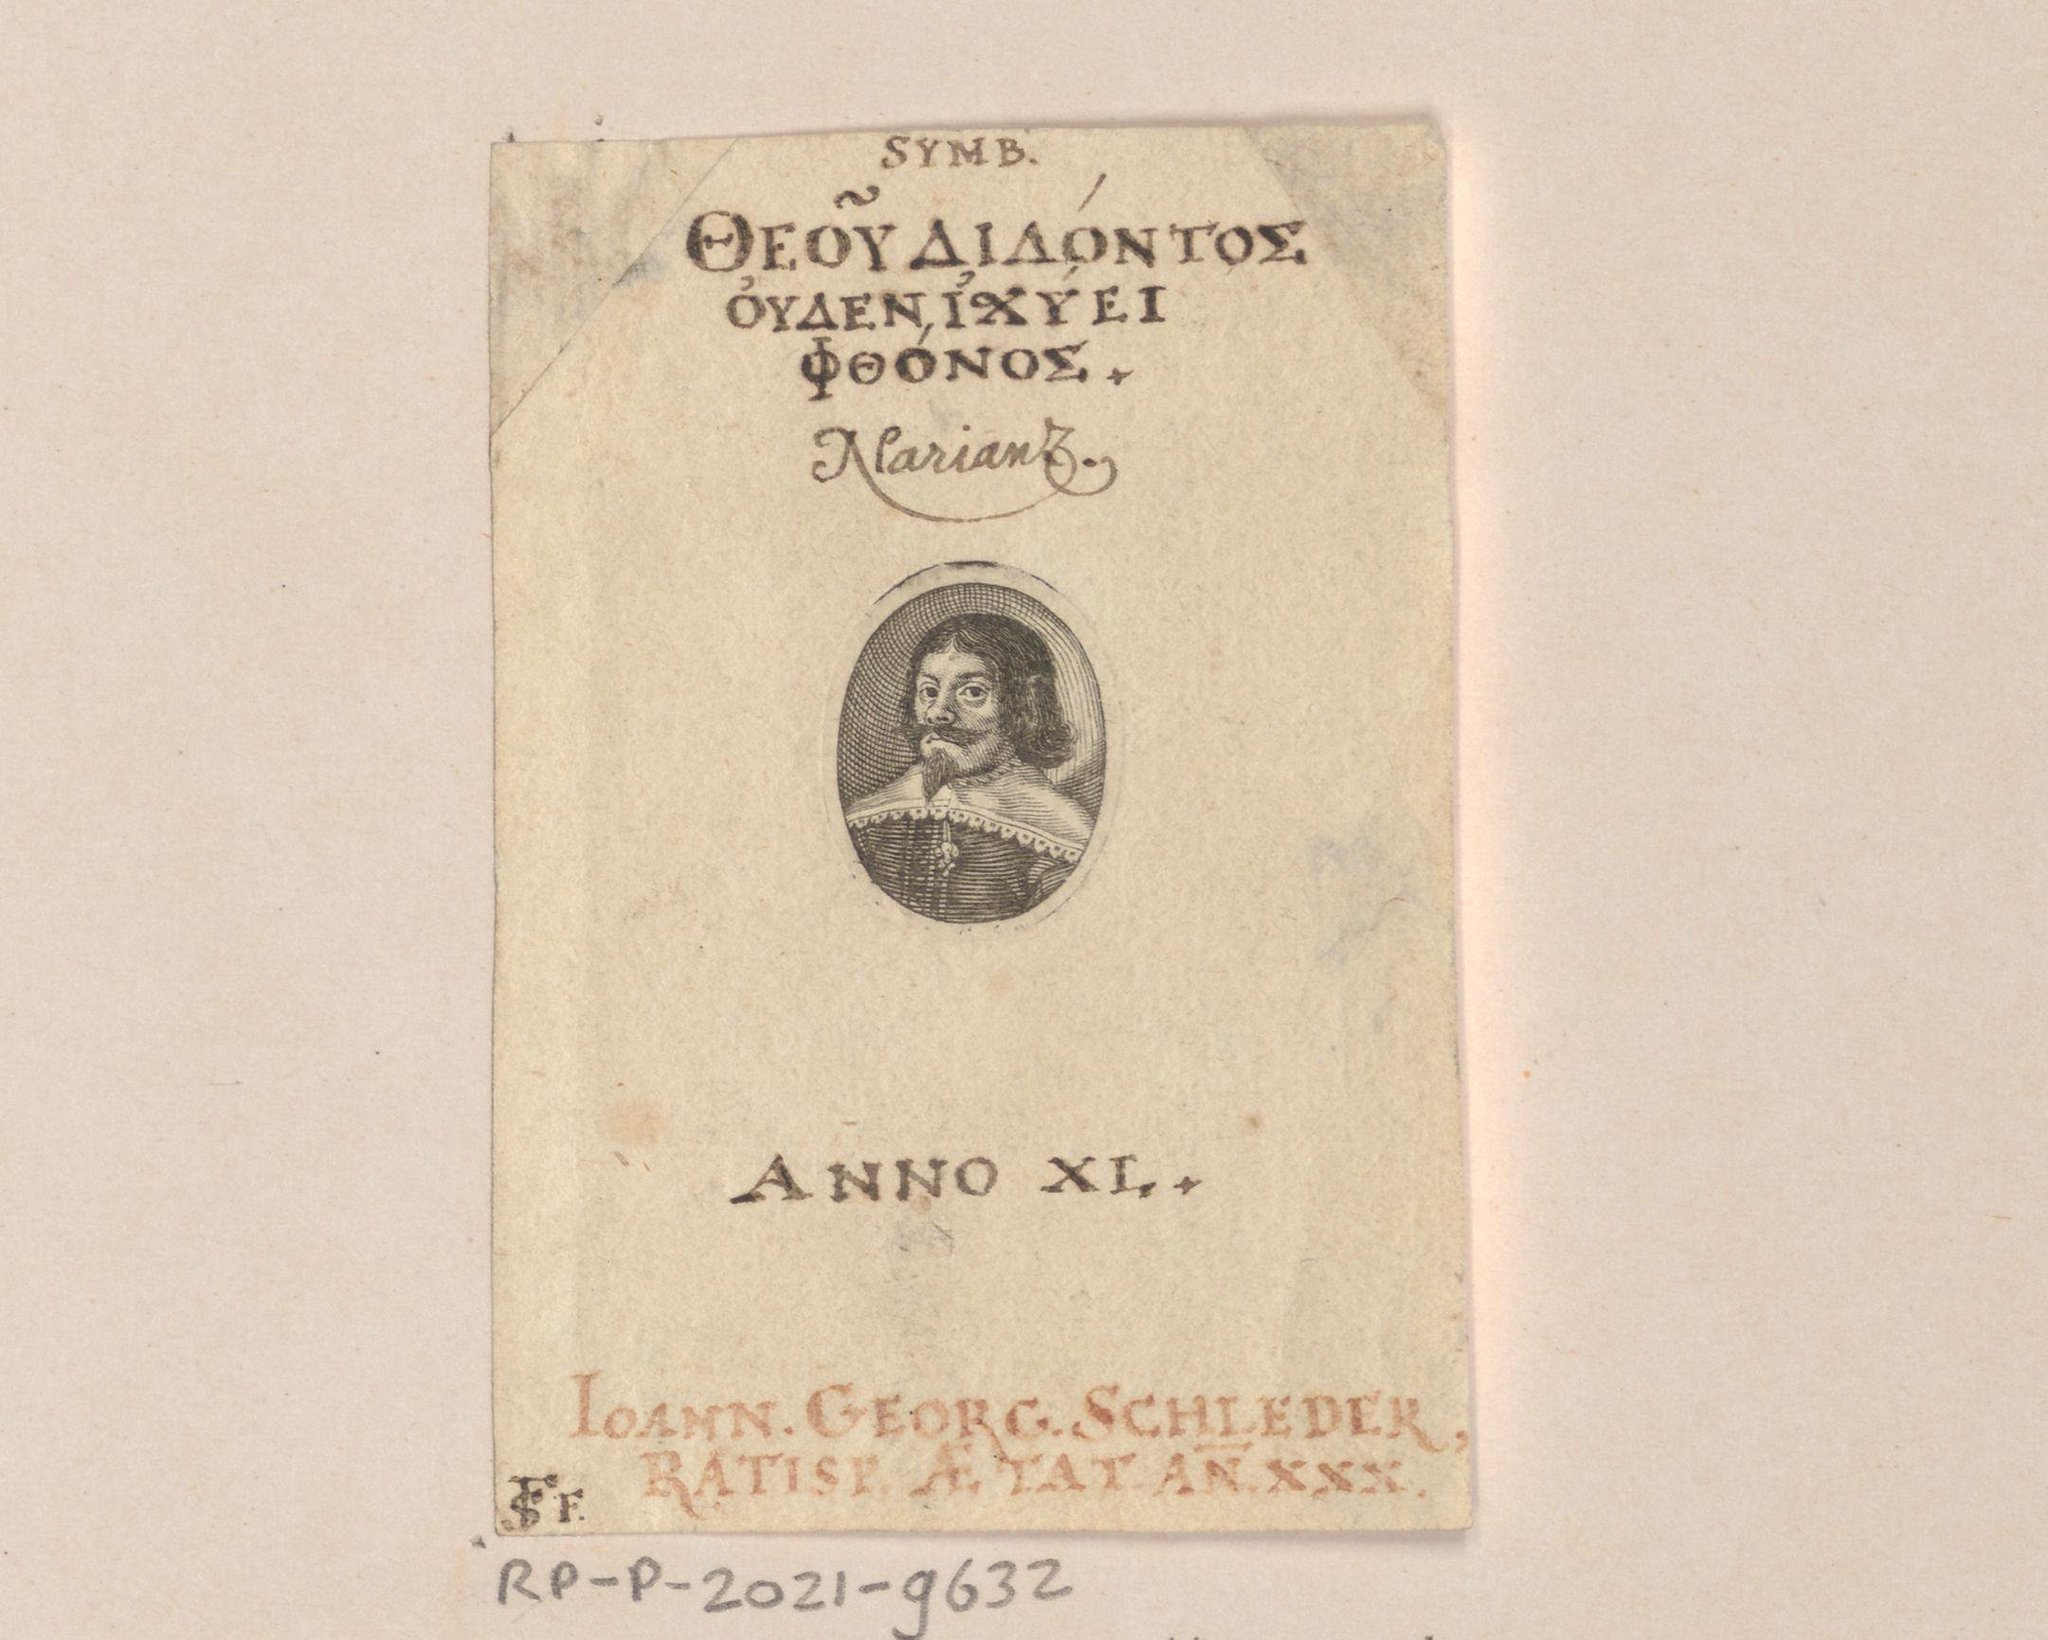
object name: print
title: Portret van Johann Georg Schleder op 30-jarige leeftijd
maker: Anonymous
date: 1650-1749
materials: ink, paper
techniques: engraving, pen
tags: johann georg schleder, historical persons, writer, poet, author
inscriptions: monogram: ‘SF F.’